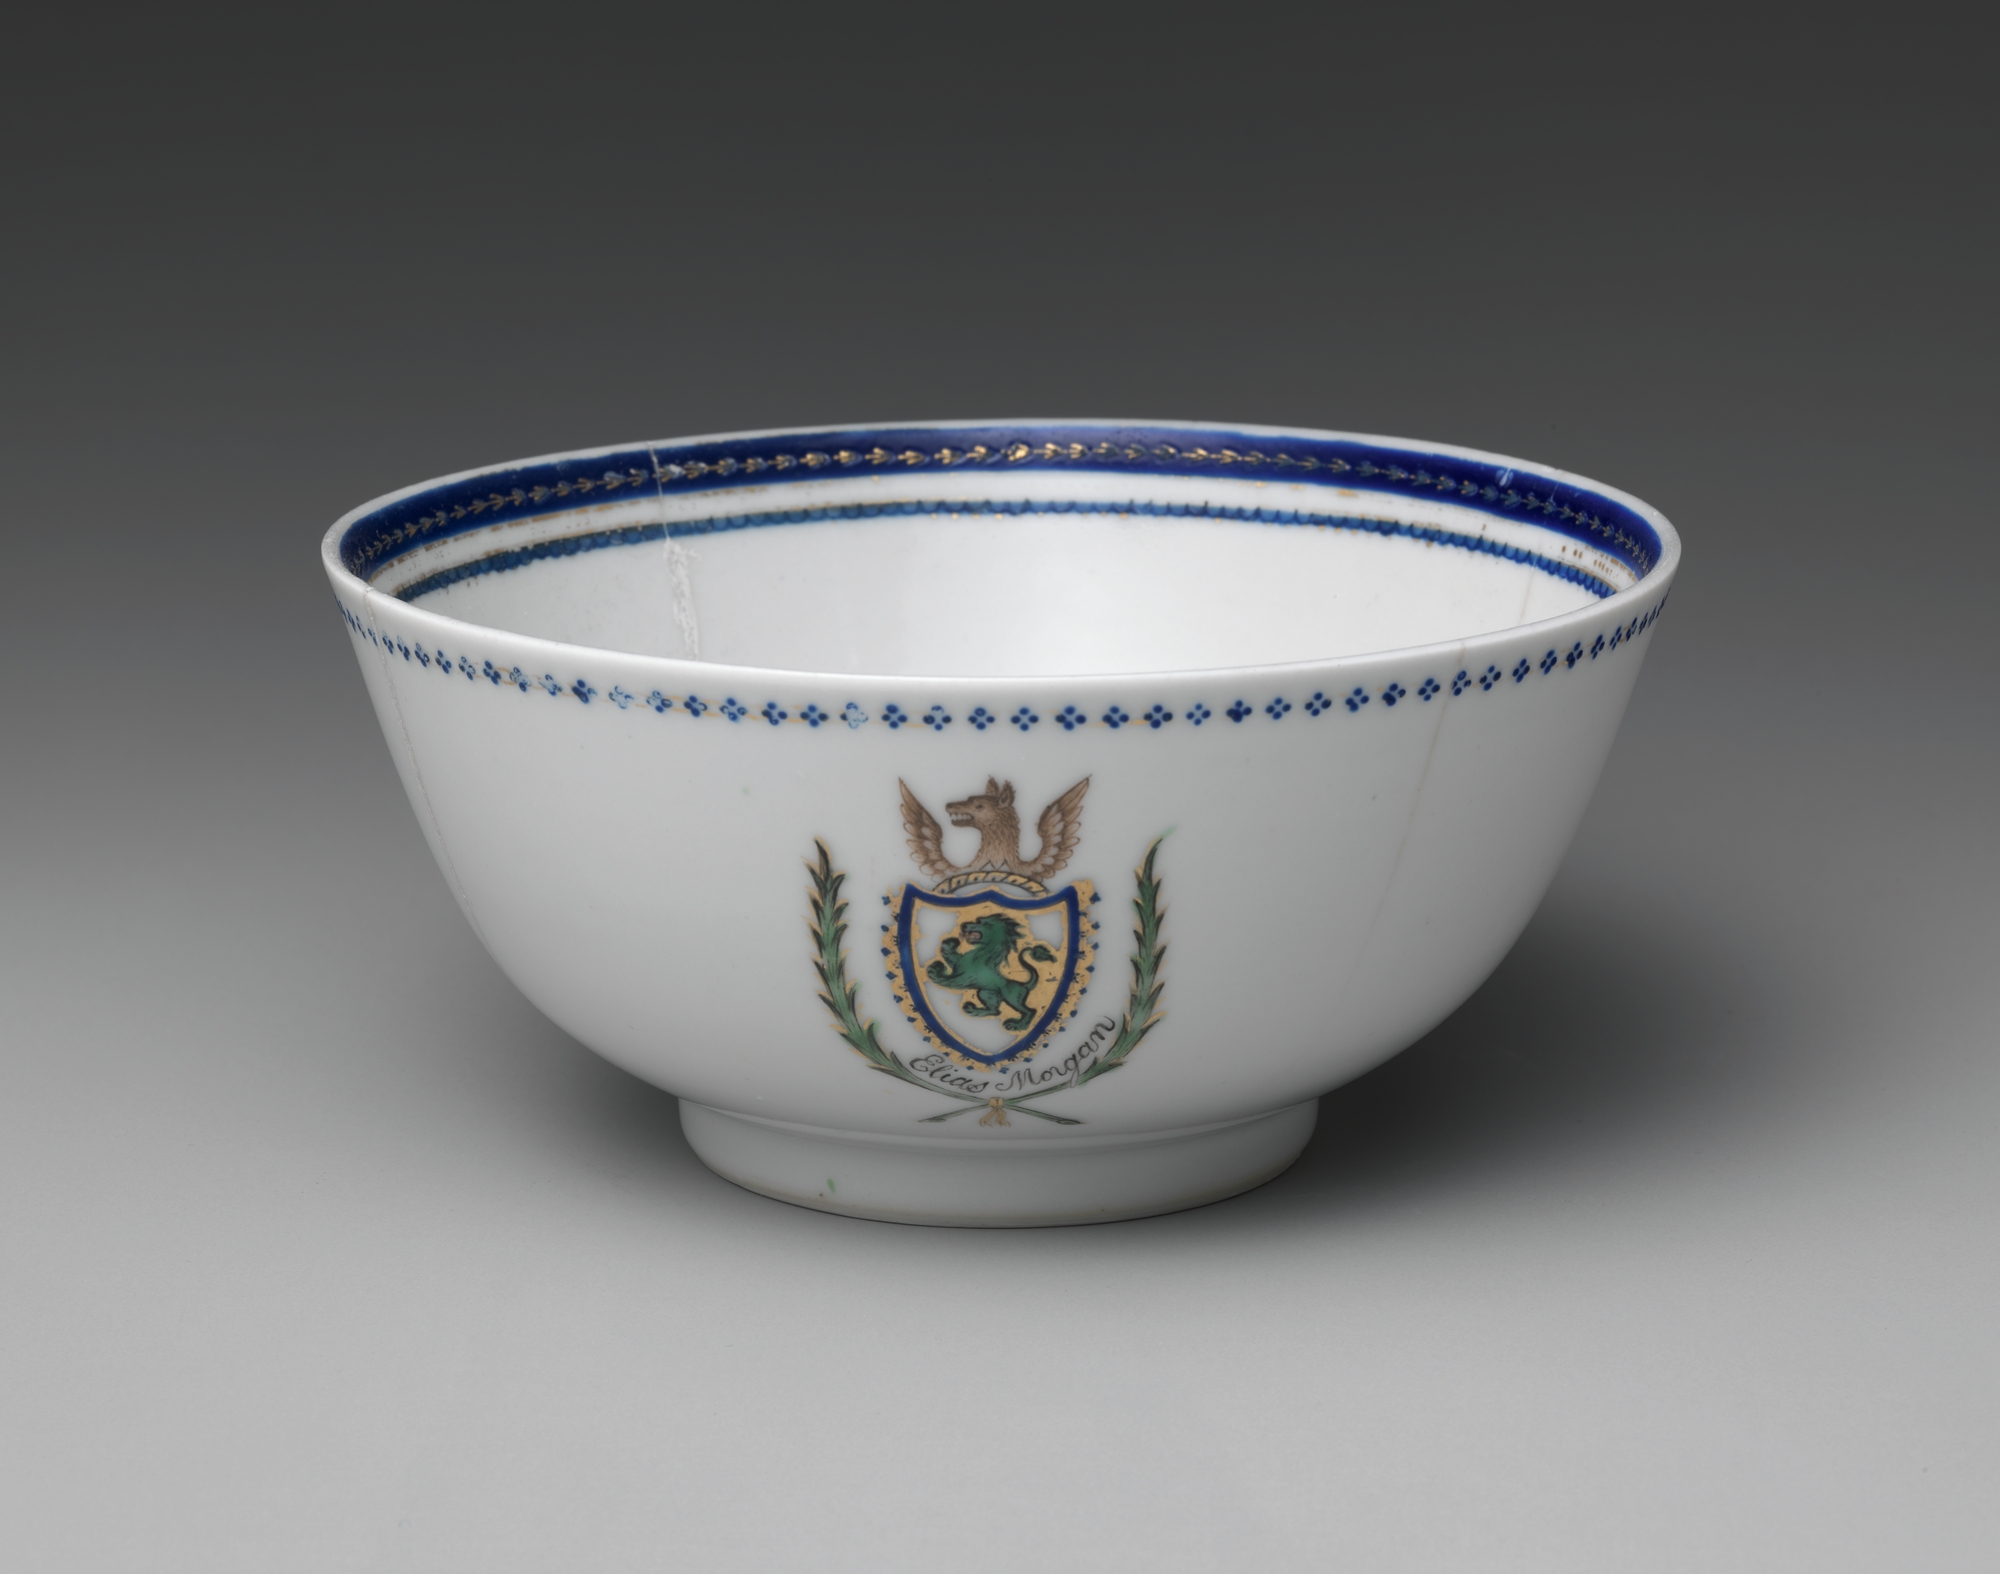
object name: bowl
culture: chinese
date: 1785-1790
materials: porcelain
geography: china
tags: coat of arms